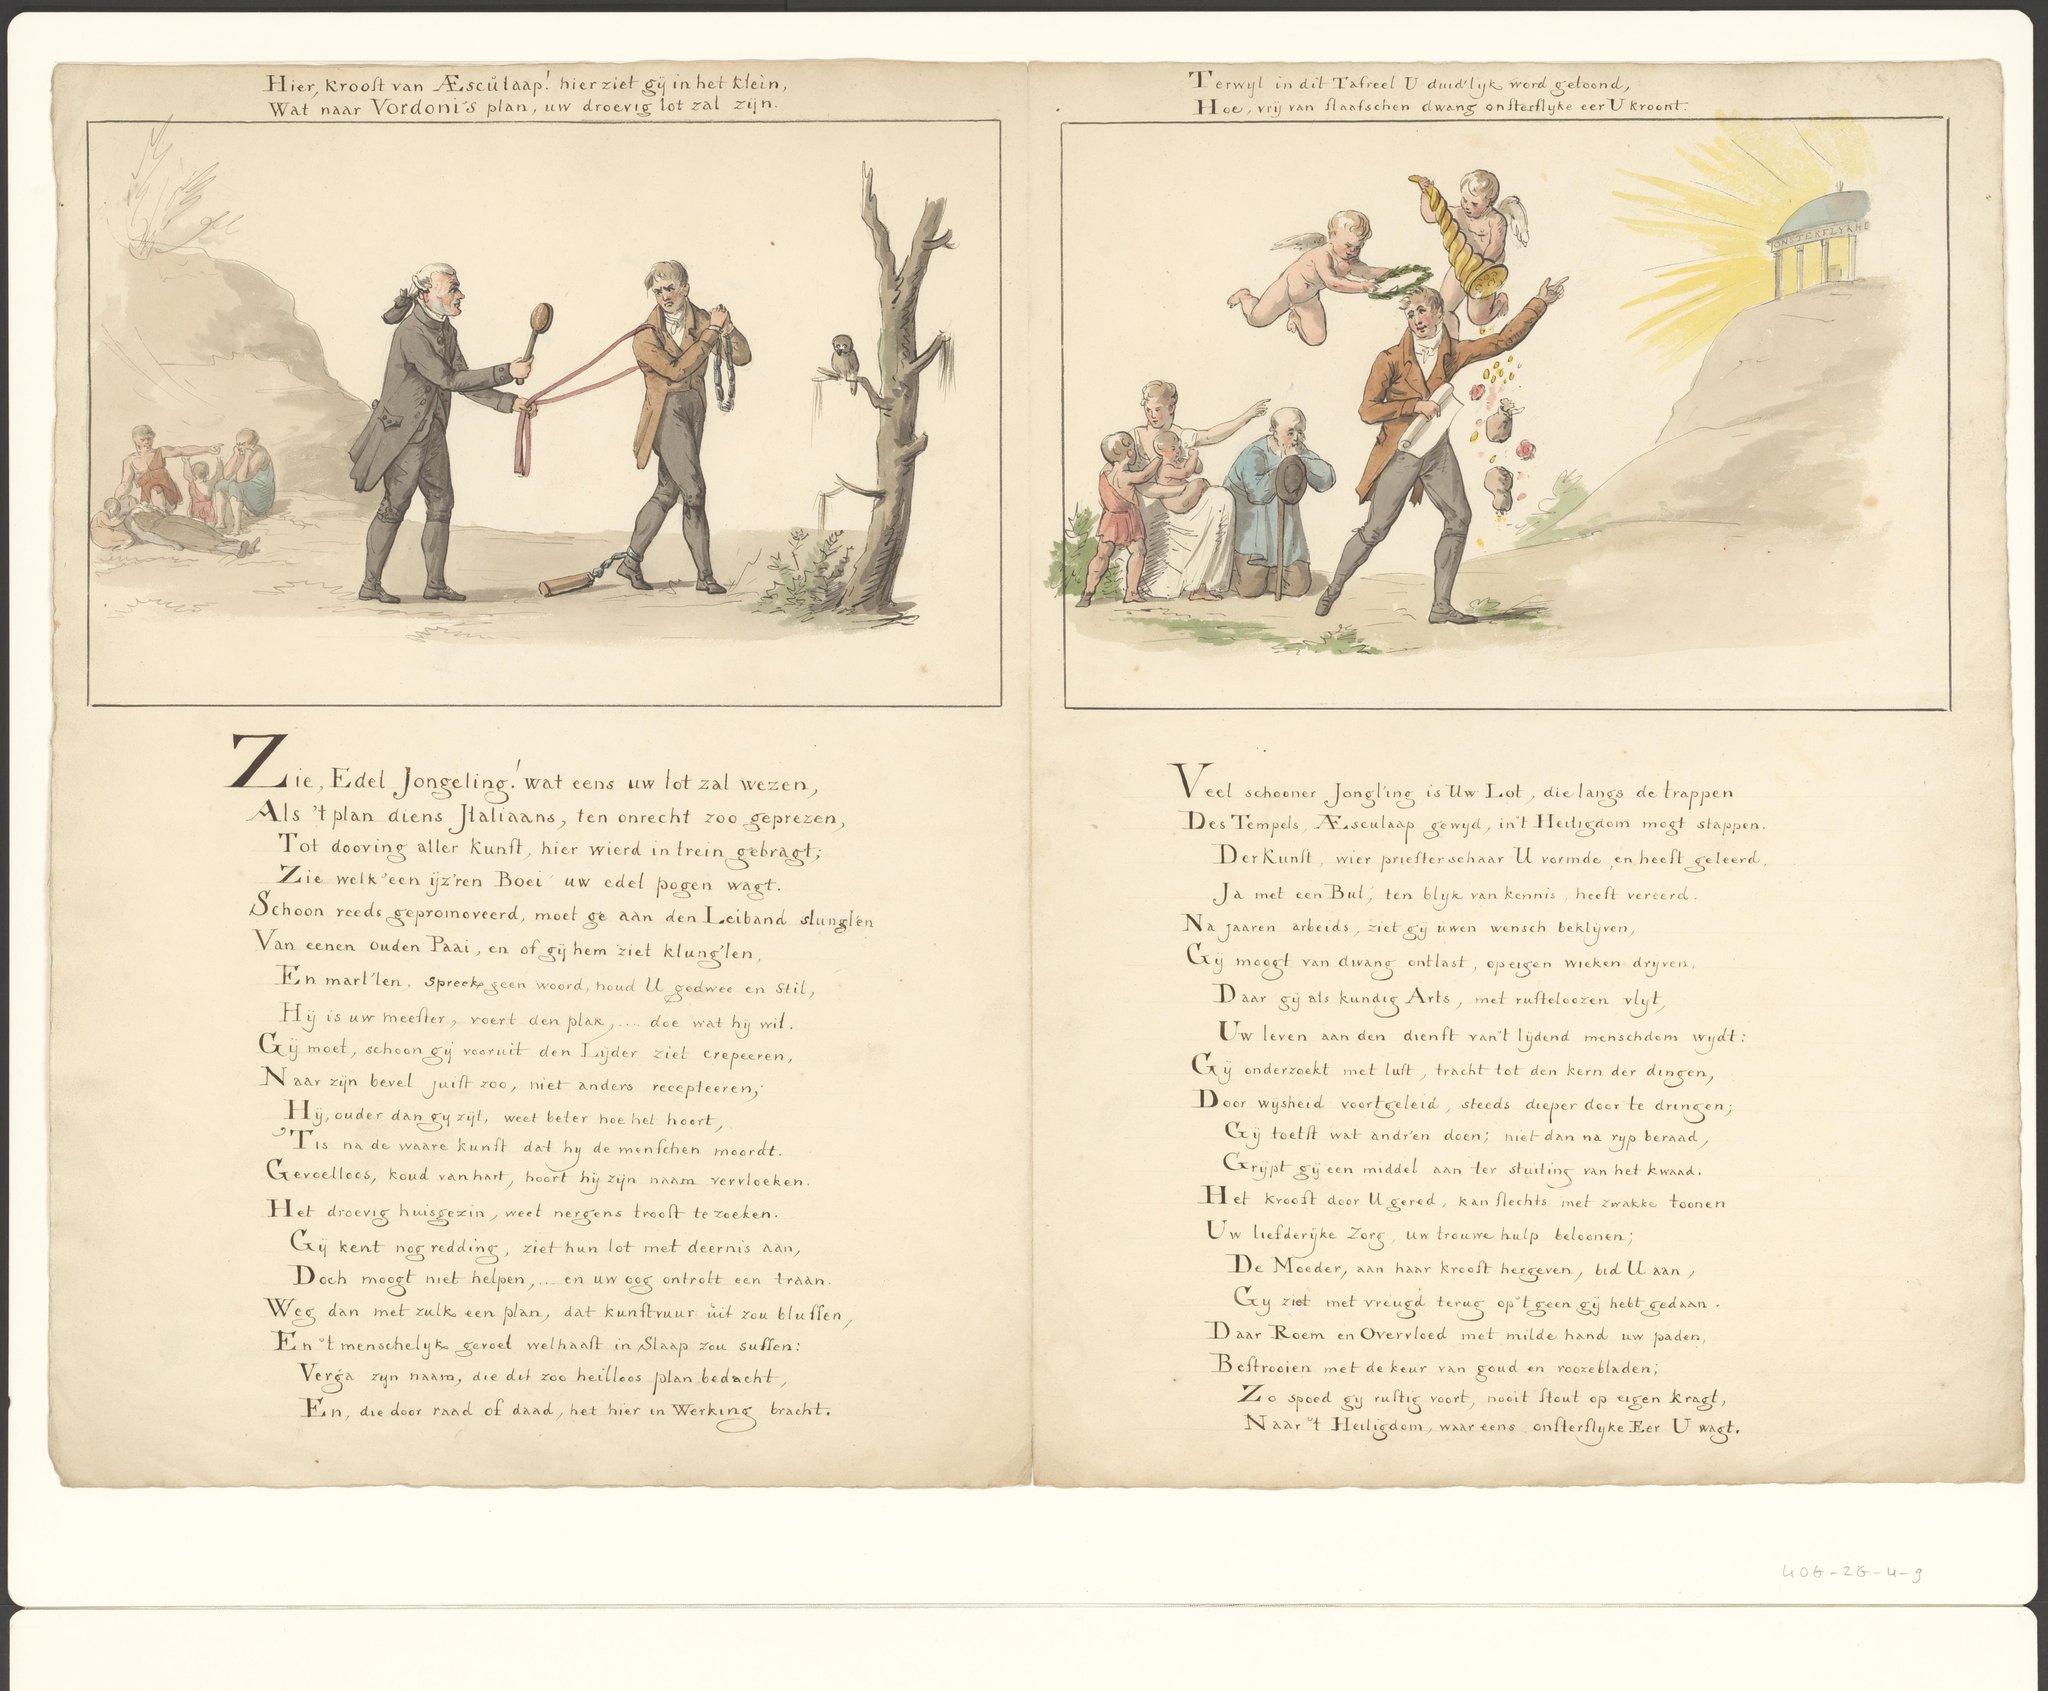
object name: drawing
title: Geïllustreerd gedicht, waarschijnlijk ter gelegenheid van de promotie van Daniel Dijlius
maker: jacob willemz. de vos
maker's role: draughtsman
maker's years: 1774-1844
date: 1798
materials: ink, paper, watercolor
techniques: brush, pen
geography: netherlands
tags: utrecht, 'cornucopia', horn of plenty, receiving doctor's degree, contrast between rich and poor, physician, doctor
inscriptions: collector's mark: Lugt 1641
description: Geïllustreerd gelegenheidsgedicht waarschijnlijk bij de promotie van Daniel Dijlius in 1798. Links een gedicht met een tekening waarop een geketende jonge arts aan de leiband loopt van een ouderwets geklede heer met een plak in de hand. Volgens de tekst stelt deze laatste de Italiaanse arts Leonardo Vordoni voor. Links op de tekening een wanhopig gezin rond een stervende moeder. Rechts een gedicht met een tekening van dezelfde jonge arts met een bul in de hand, klaar om, volgens het gedicht, op moderne wijze de geneeskunde uit te oefenen. Engelen gieten rijkdommen uit hoornen van overvloed over hem uit. Links een gezond en dankbaar gezin. Rechts de tempel van de onsterfelijkheid.